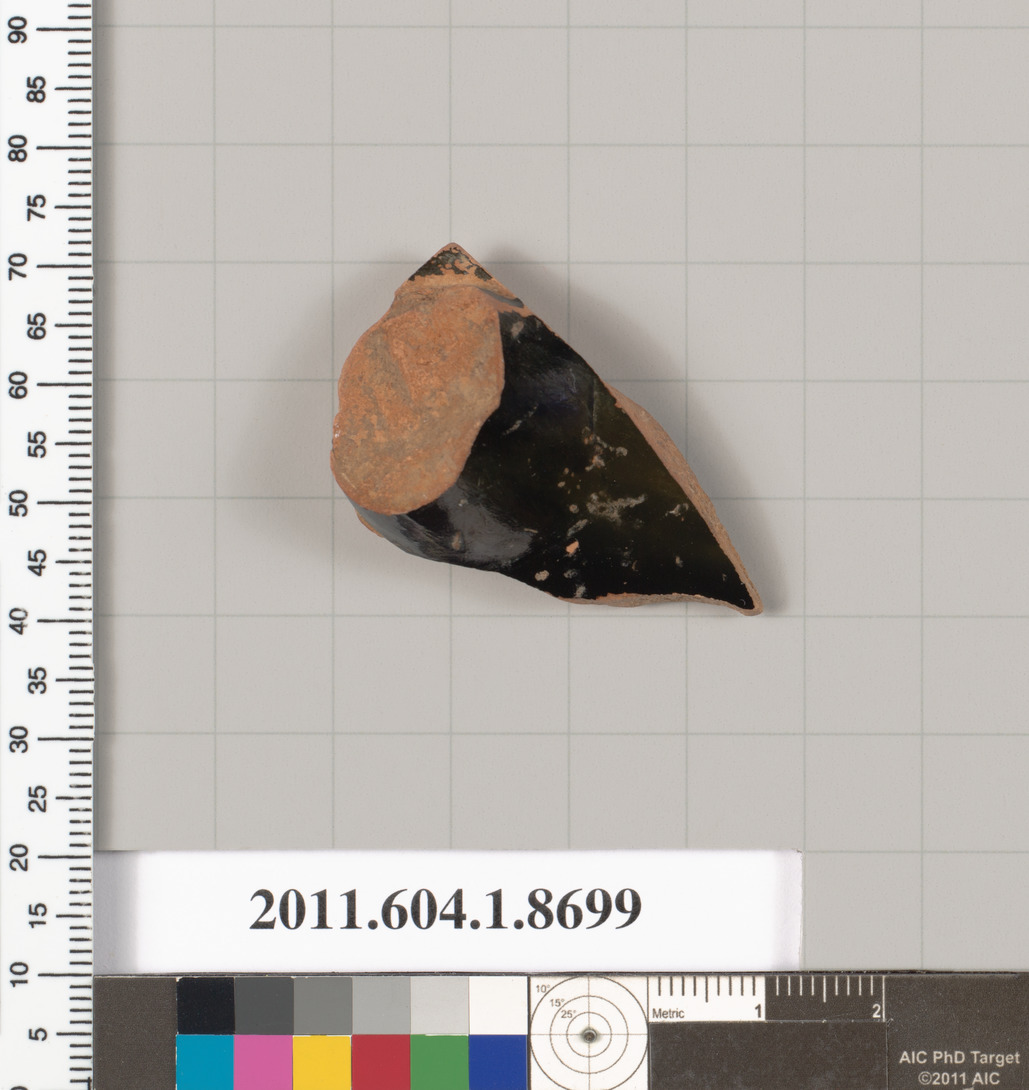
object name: kylix fragment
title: Terracotta fragment of a stemless kylix (drinking cup)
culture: greek, attic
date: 470-450 BCE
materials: terracotta